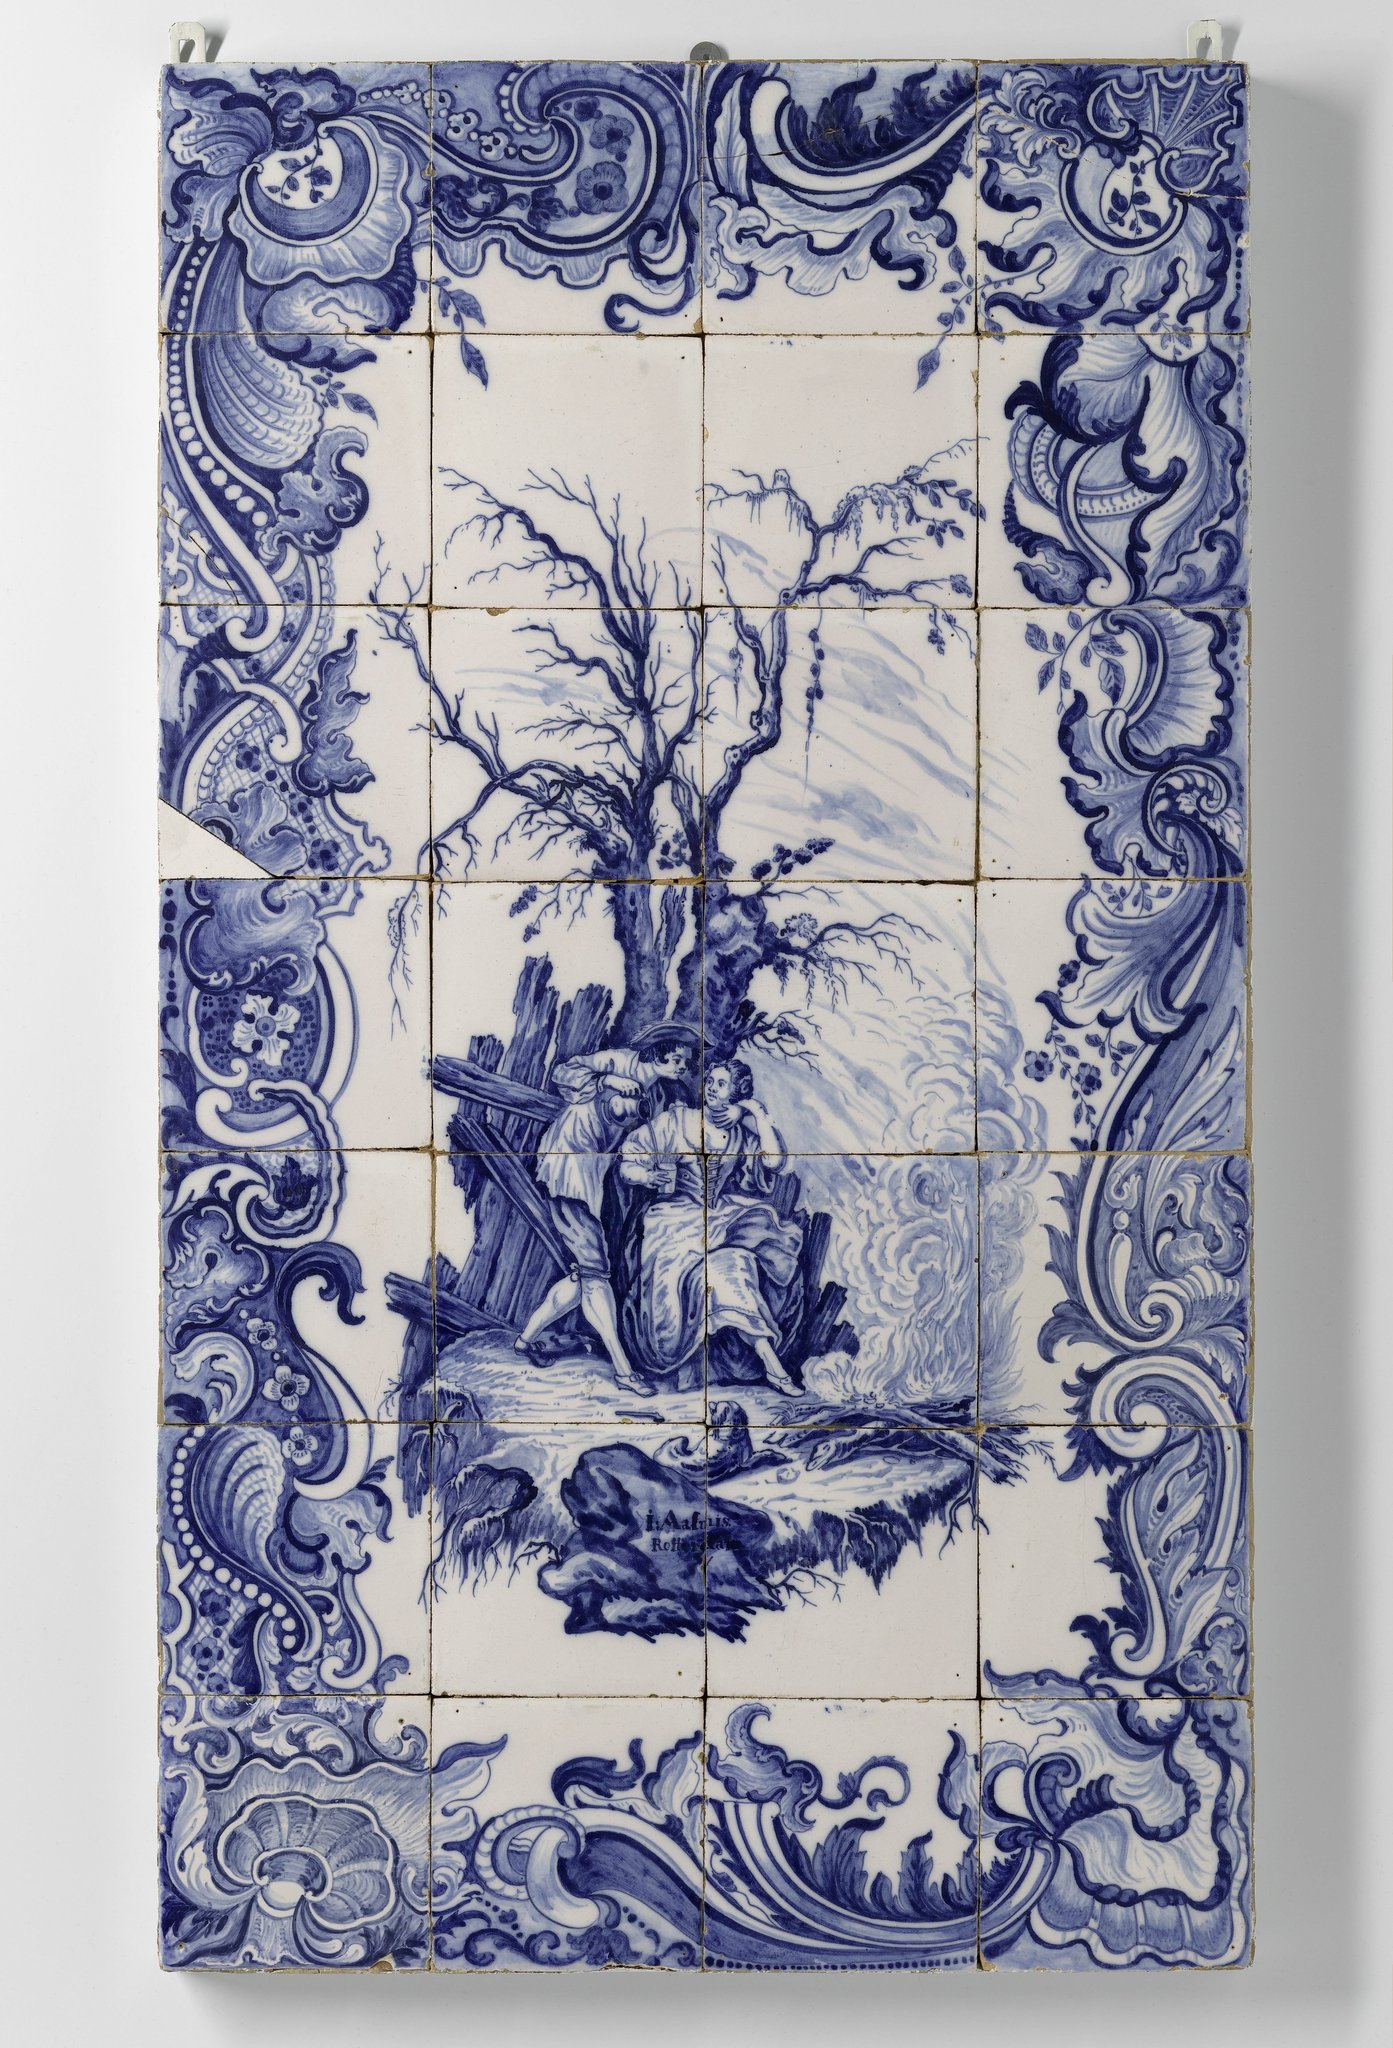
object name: tile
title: Tegeltableau met in blauw geschilderde voorstelling van één van de vier jaargetijden: de winter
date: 1760-1780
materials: earthenware, glaze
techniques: maiolica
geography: rotterdam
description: Tegeltableau van achtentwintig tegels (7 x 4) met een blauw geschilderde voorstelling van een man die met een kan het glas van een vrouw volschenkt. Deze voorstelling stelt één van de vier jaargetijden, de winter voor en is omgeven door een omlijsting van rococo ornament. Gesigneerd: I: Aalmis Rotterdam.